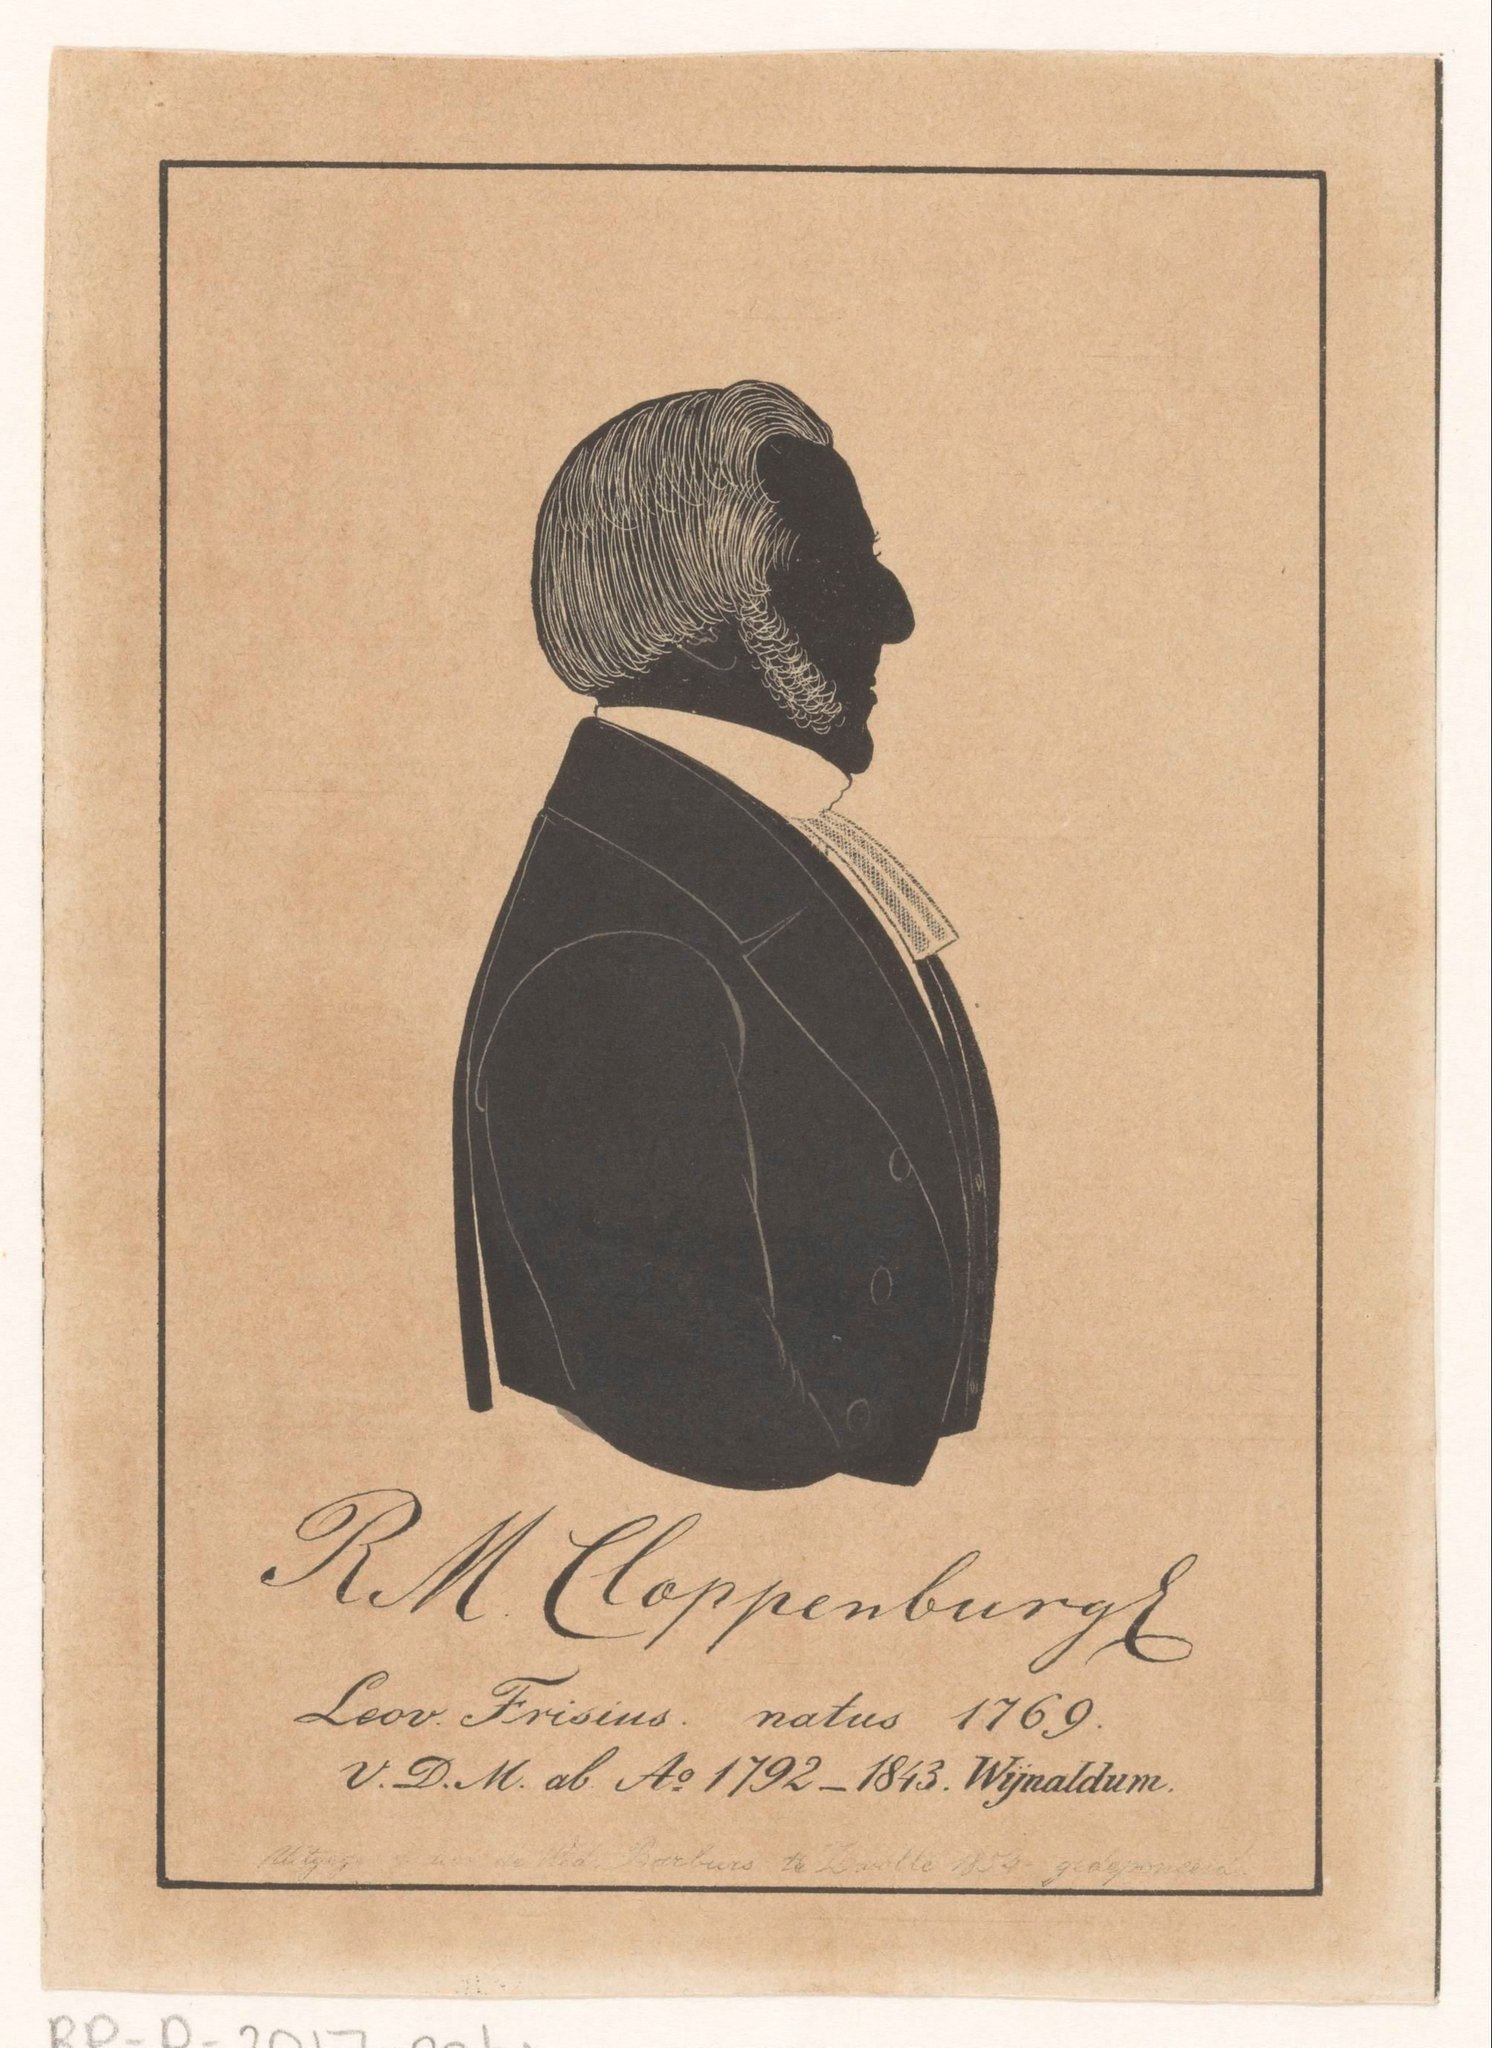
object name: print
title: Silhouetportret van Reinder Matthijs Cloppenburg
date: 1854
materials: paper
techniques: hand coloring, lithograph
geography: zwolle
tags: historical persons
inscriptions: collector's mark: Lugt 2228, : ‘Gedeponeerd.’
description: Onder het portret de signatuur van de geportretteerde.